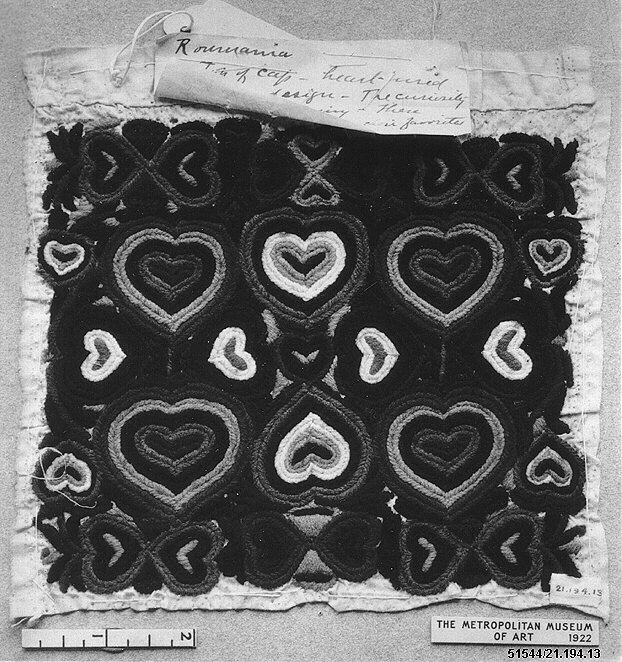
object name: cap crown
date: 1801-1900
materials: linen, wool